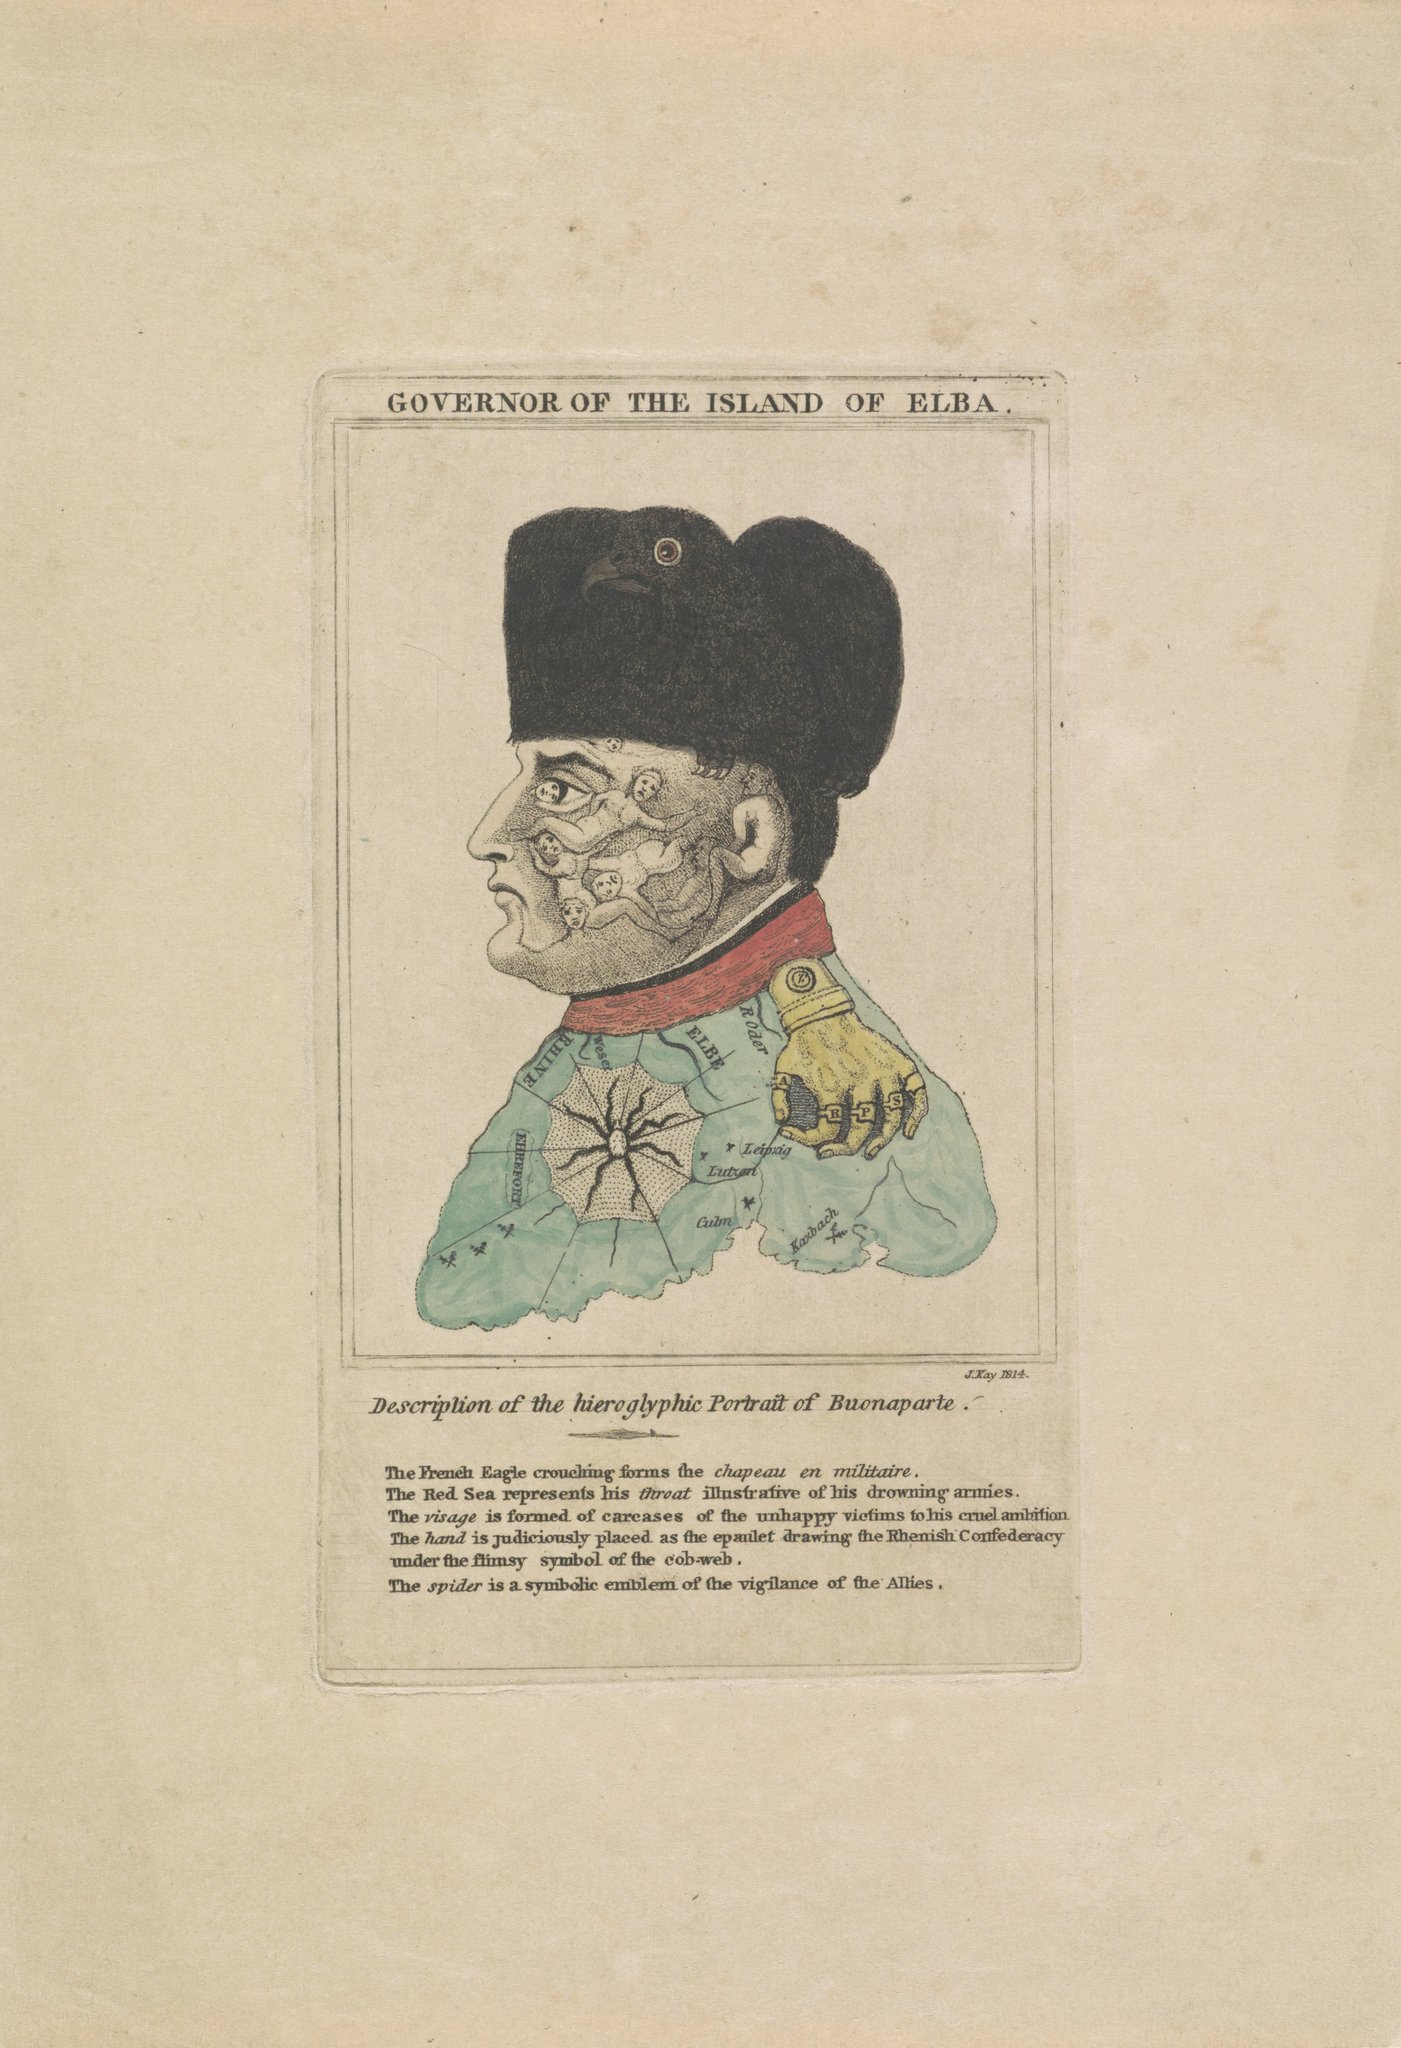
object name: cartoon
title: Spotprent op Napoleon, 1814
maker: john kay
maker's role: print maker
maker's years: 1742-1826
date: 1814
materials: paper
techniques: etching, hand coloring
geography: england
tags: napoleon i (emperor of the french), political caricatures and satires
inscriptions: collector's mark: Lugt 2228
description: Spotprent op Napoleon van 1814 waarbij zijn gezicht is opgebouwd uit de lijken van zijn slachtoffers, zijn hoed is de Pruisische adelaar, zijn epaulet is een grijpende hand waarvan de vingers ringen dragen met de letters A, R, P en S. De kraag is een rivier van bloed, zijn jas het slagveld van Europa en het ordeteken van het Legioen van Eer op zijn borst is een spinnenweb. Ten tijde van zijn verbanning naar Elba. In het onderschrift een zesregelige verklaring in het Engels.